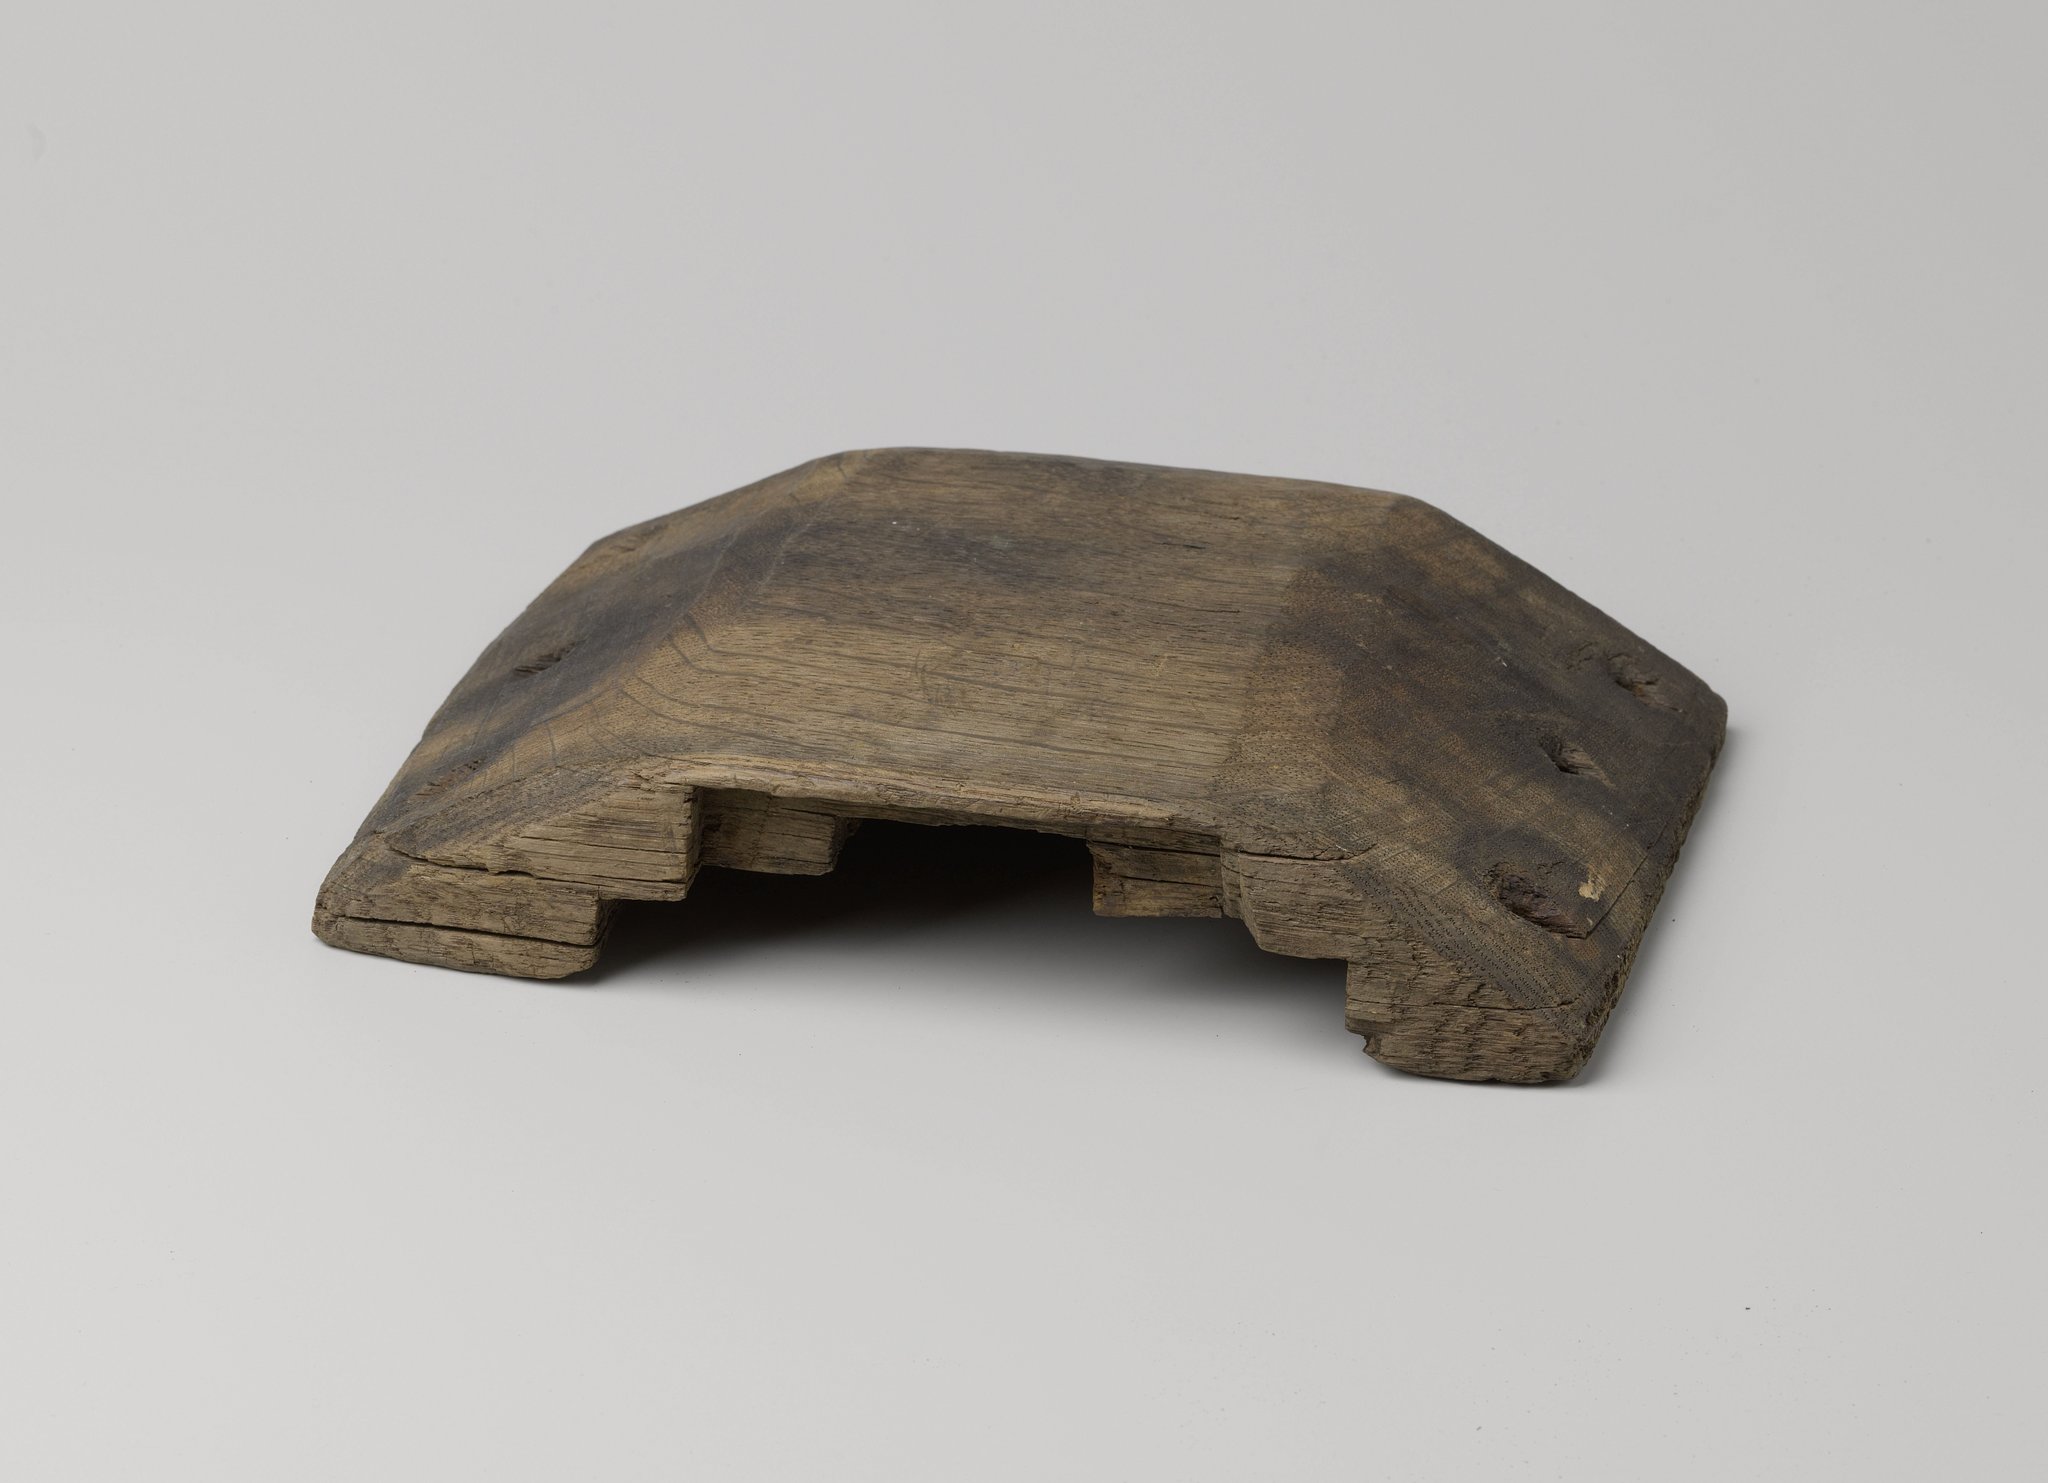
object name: fragment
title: Fragment van omkasting of klos van slot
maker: Anonymous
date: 1590-1596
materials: wood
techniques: cutting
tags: willem barendsz., amsterdam, jacob van heemskerck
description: Fragment van een omkasting of klos van slot NM-7683.